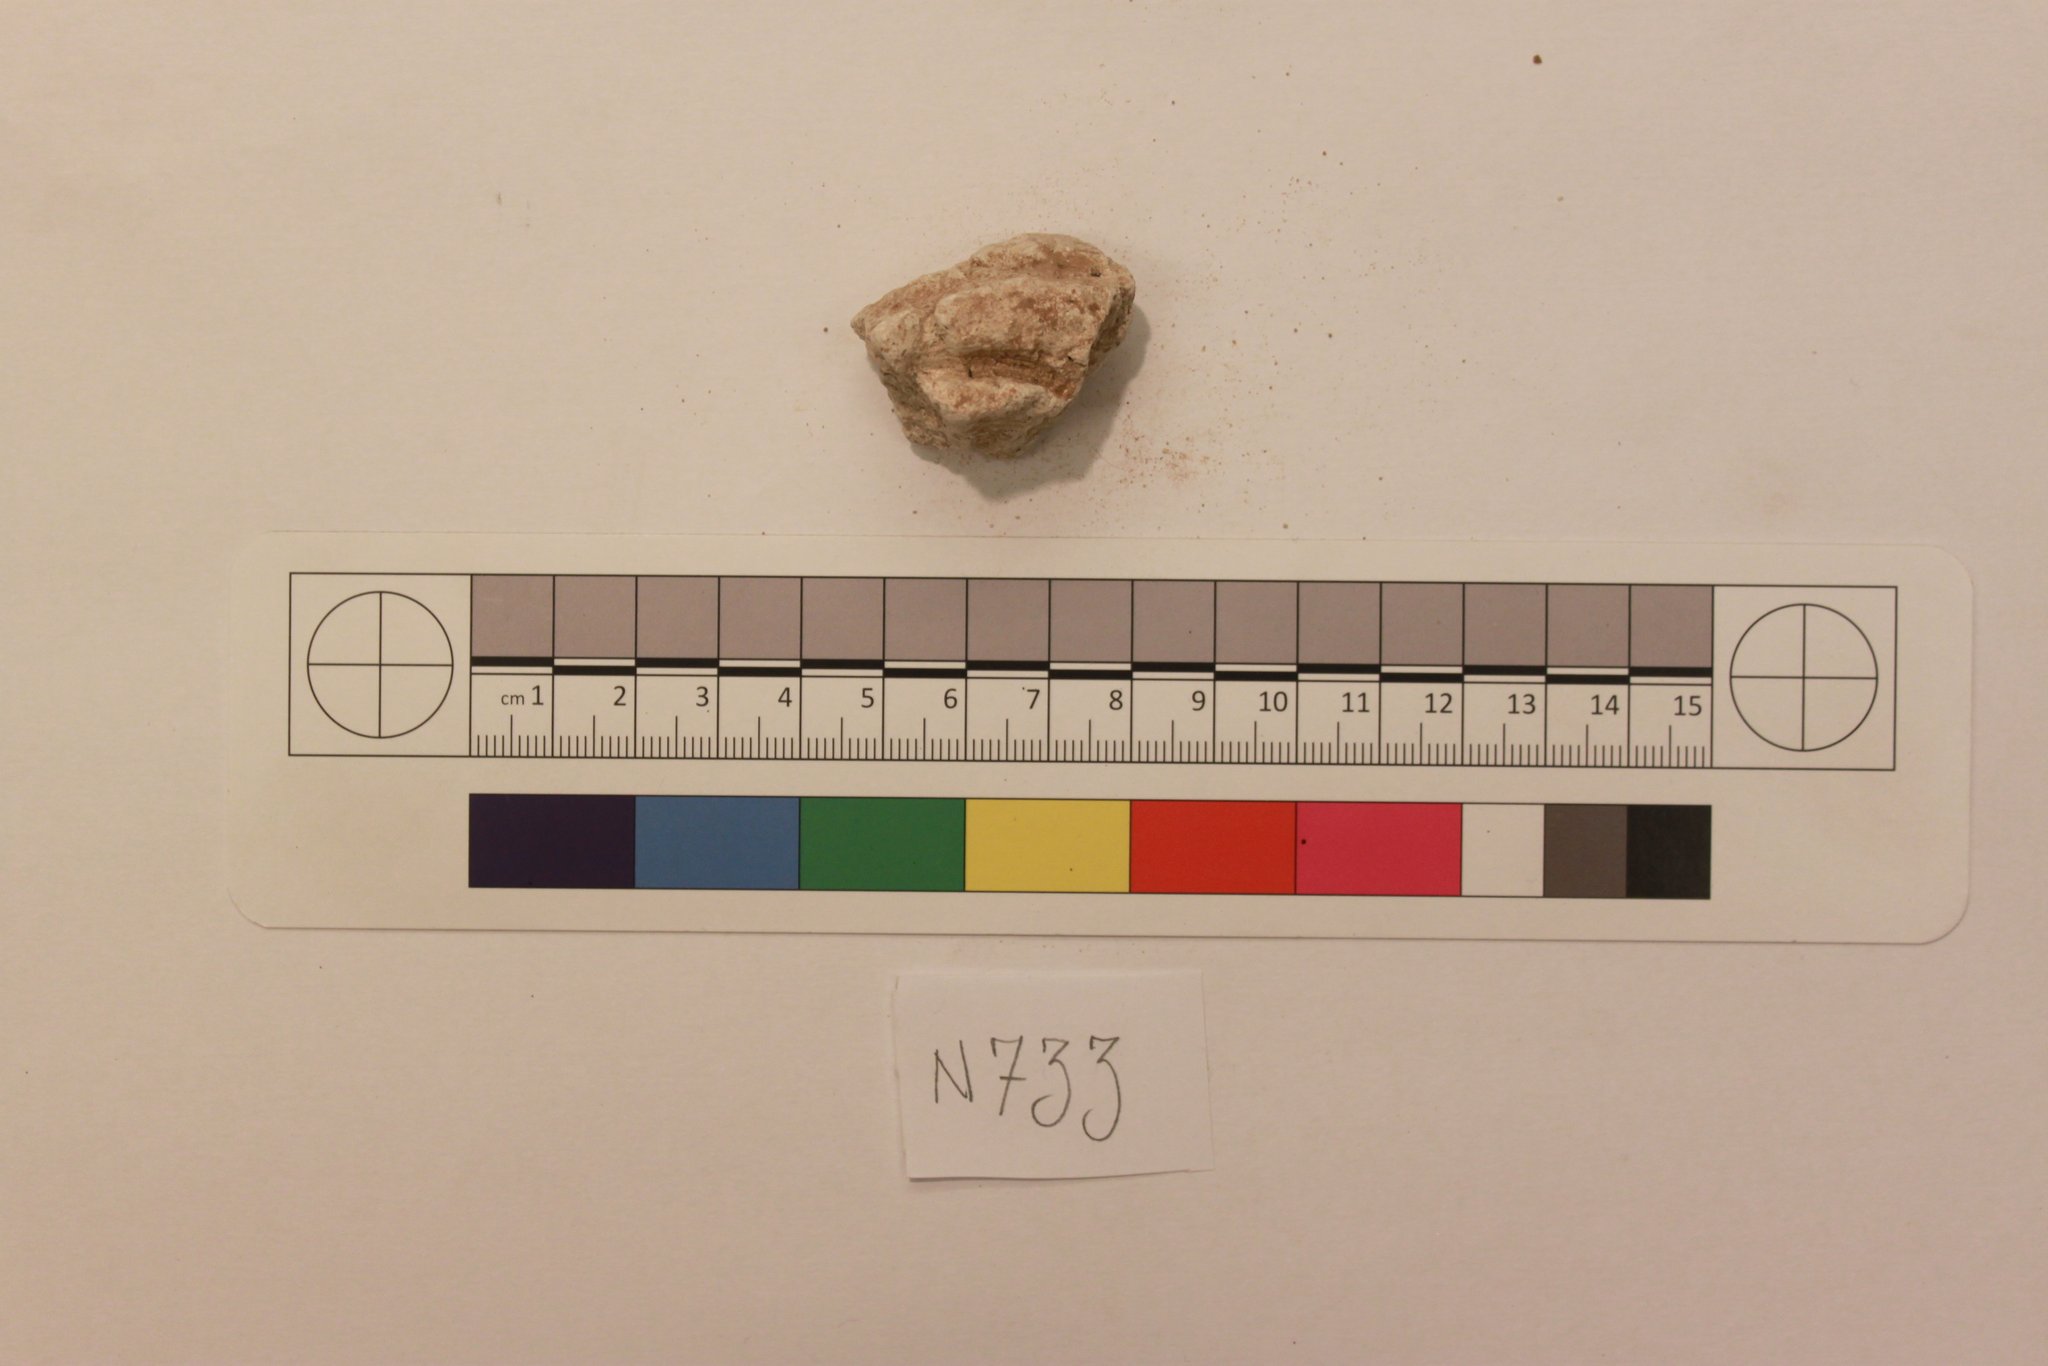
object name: fragment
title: Stucco Fragment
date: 701-1200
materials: plaster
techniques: carving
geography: iran